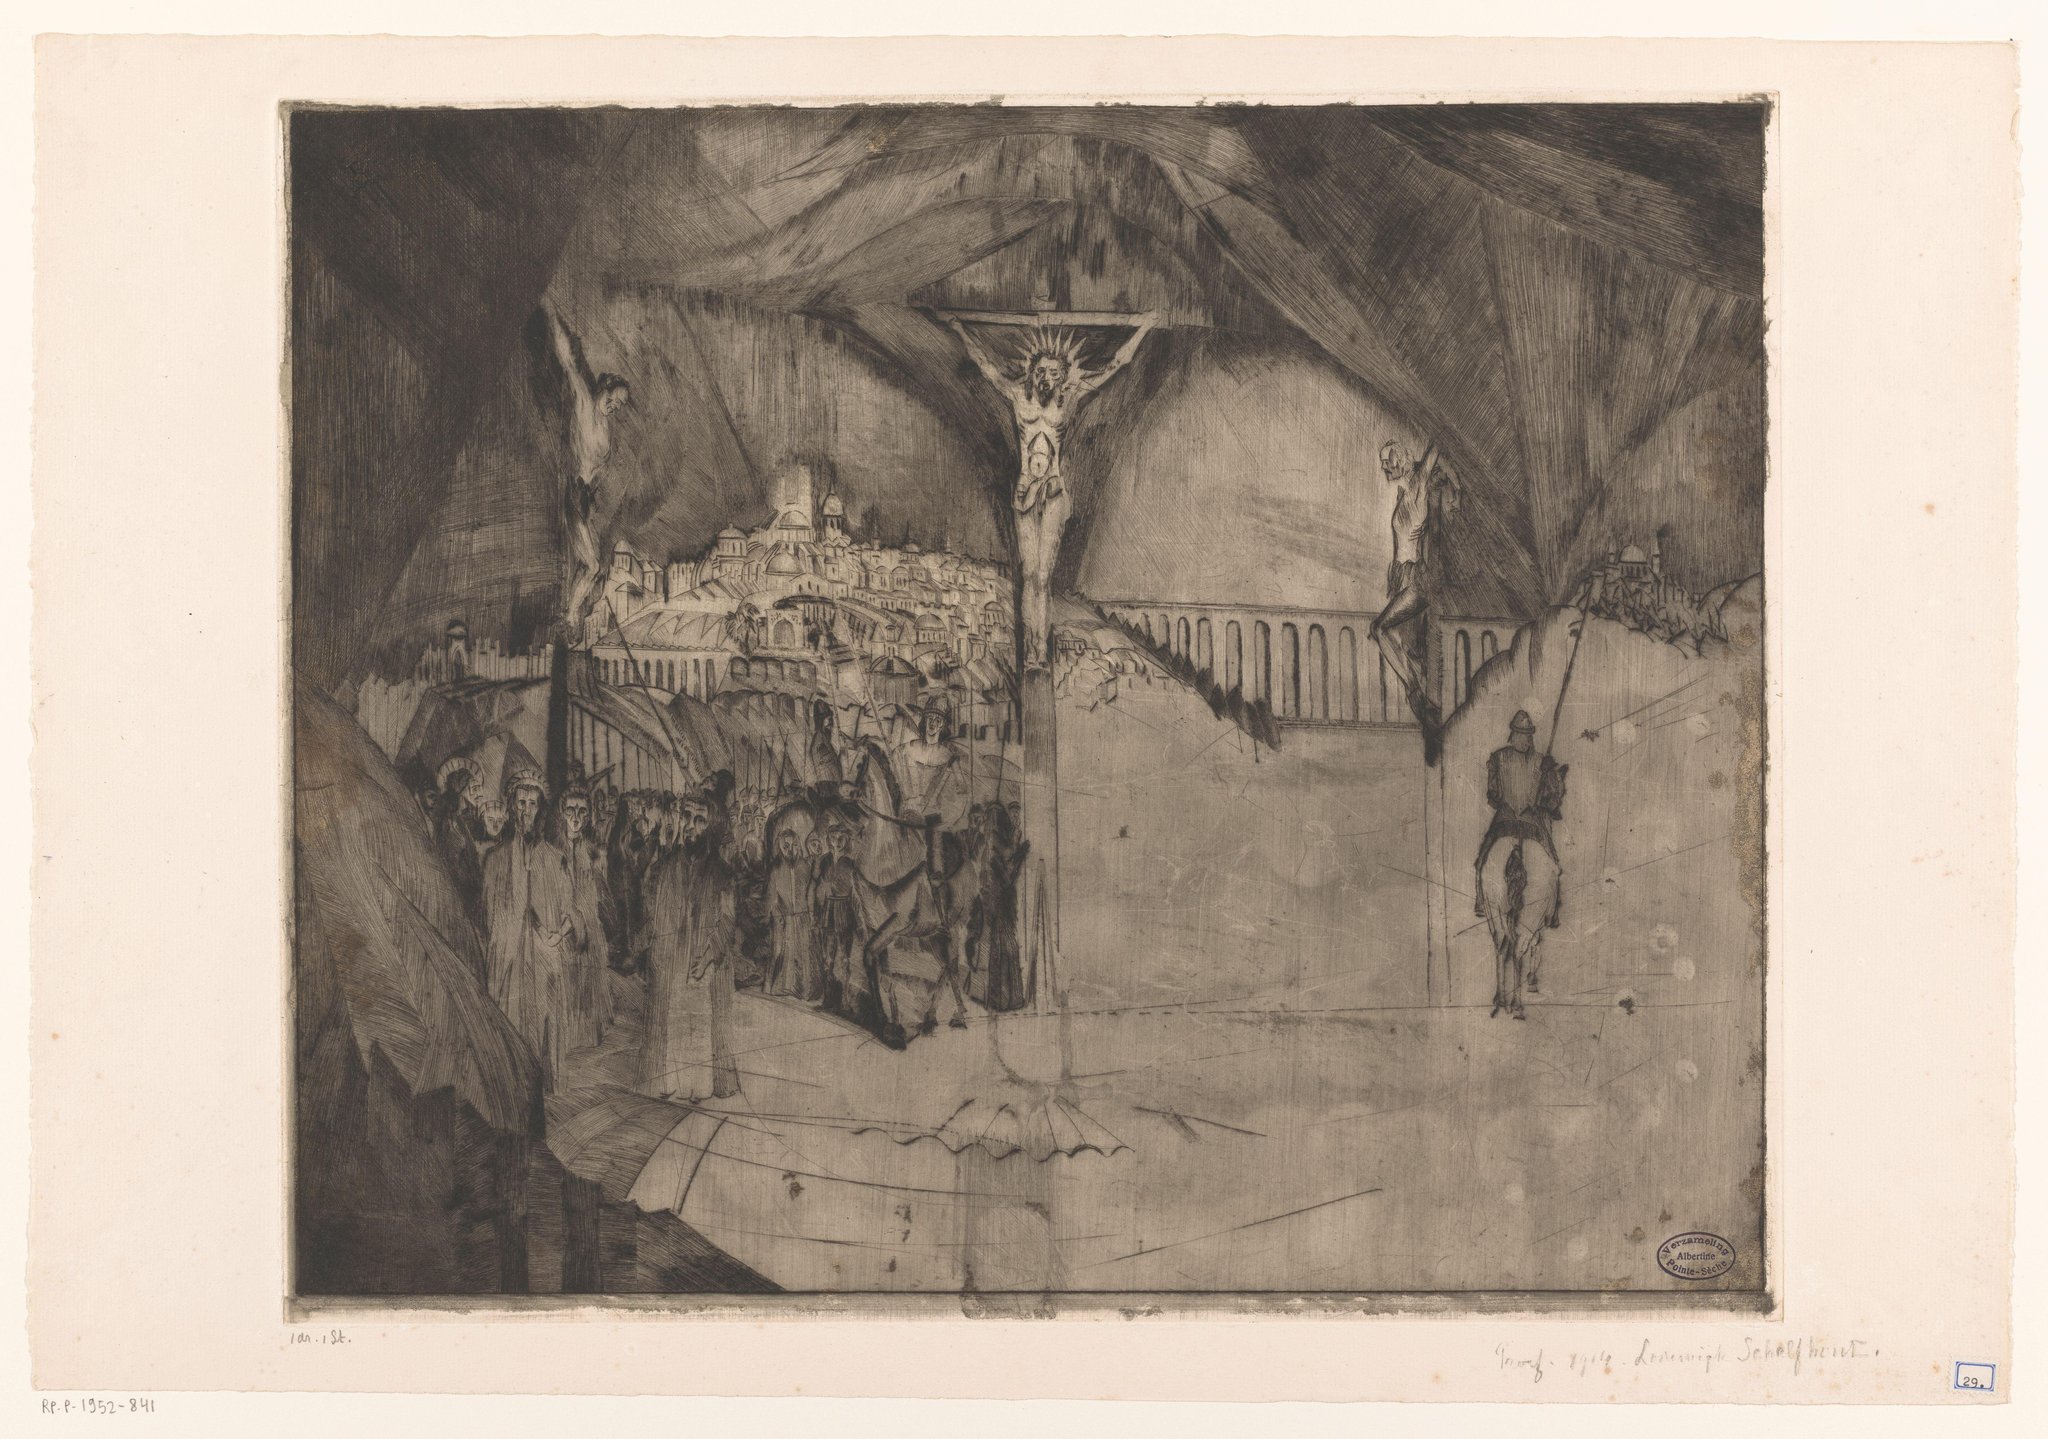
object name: print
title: Golgotha I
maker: lodewijk schelfhout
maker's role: draughtsman, print maker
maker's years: 1881-1943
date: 1914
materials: paper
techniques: drypoint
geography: netherlands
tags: city-view, and landscape with man-made constructions, the crucifixion of christ: prelude to christ's death on the cross (matthew 27:34-44; mark 15:23-32; luke 23:33-43; john 19:18-24)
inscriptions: collector's mark: Lugt 5i, collector's mark: Lugt 2760, collector's mark: Lugt 2228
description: Christus en de twee misdadigers aan het kruis op de heuvel Golgota. Onder hen een menigte mensen en ruiters te paard. Op de achtergrond twee gedeelten van een stad die onderling verbonden zijn met een brug.